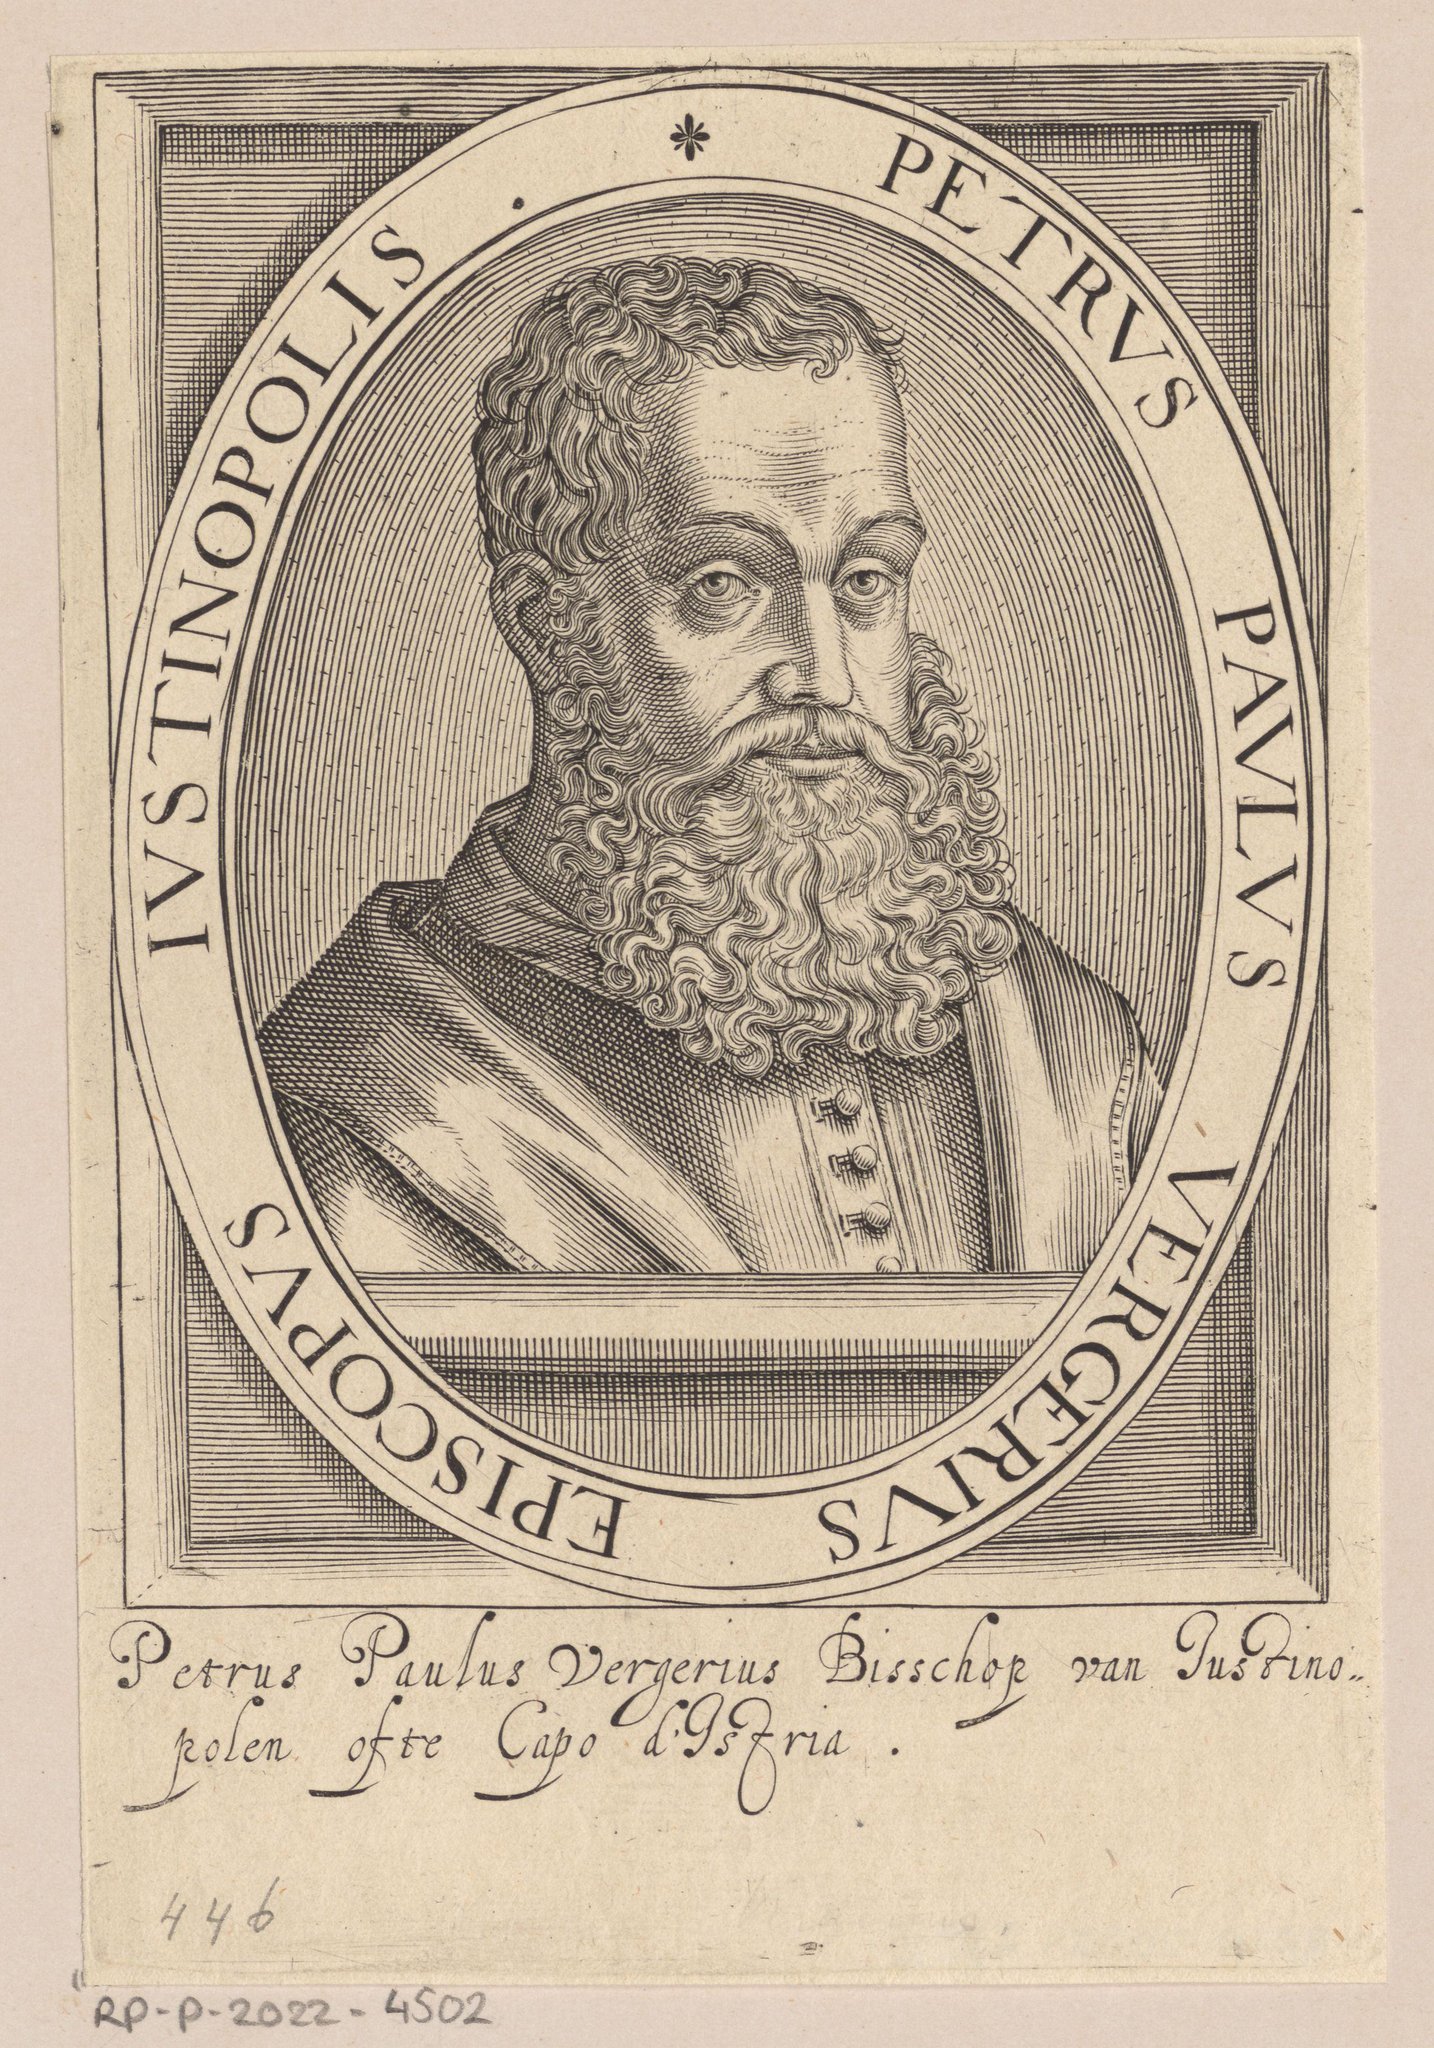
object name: print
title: Portret van Pietro Paolo Vergerio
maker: Anonymous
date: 1611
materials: paper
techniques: engraving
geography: low countries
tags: archbishop, bishop, etc. (roman catholic), historical persons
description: Prent waarschijnlijk uit: Sleidanus, Johannes. Warachtige beschryvinge hoe dattet met de religie ghestaen heeft (...). Rotterdam: Gillis Pietersz, Delft: Nicolaes de Clerck, 1611.